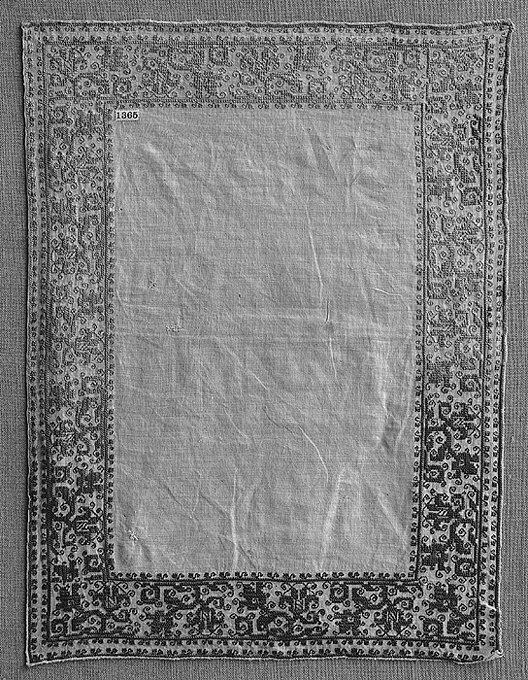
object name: cover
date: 1501-1700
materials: linen, silk